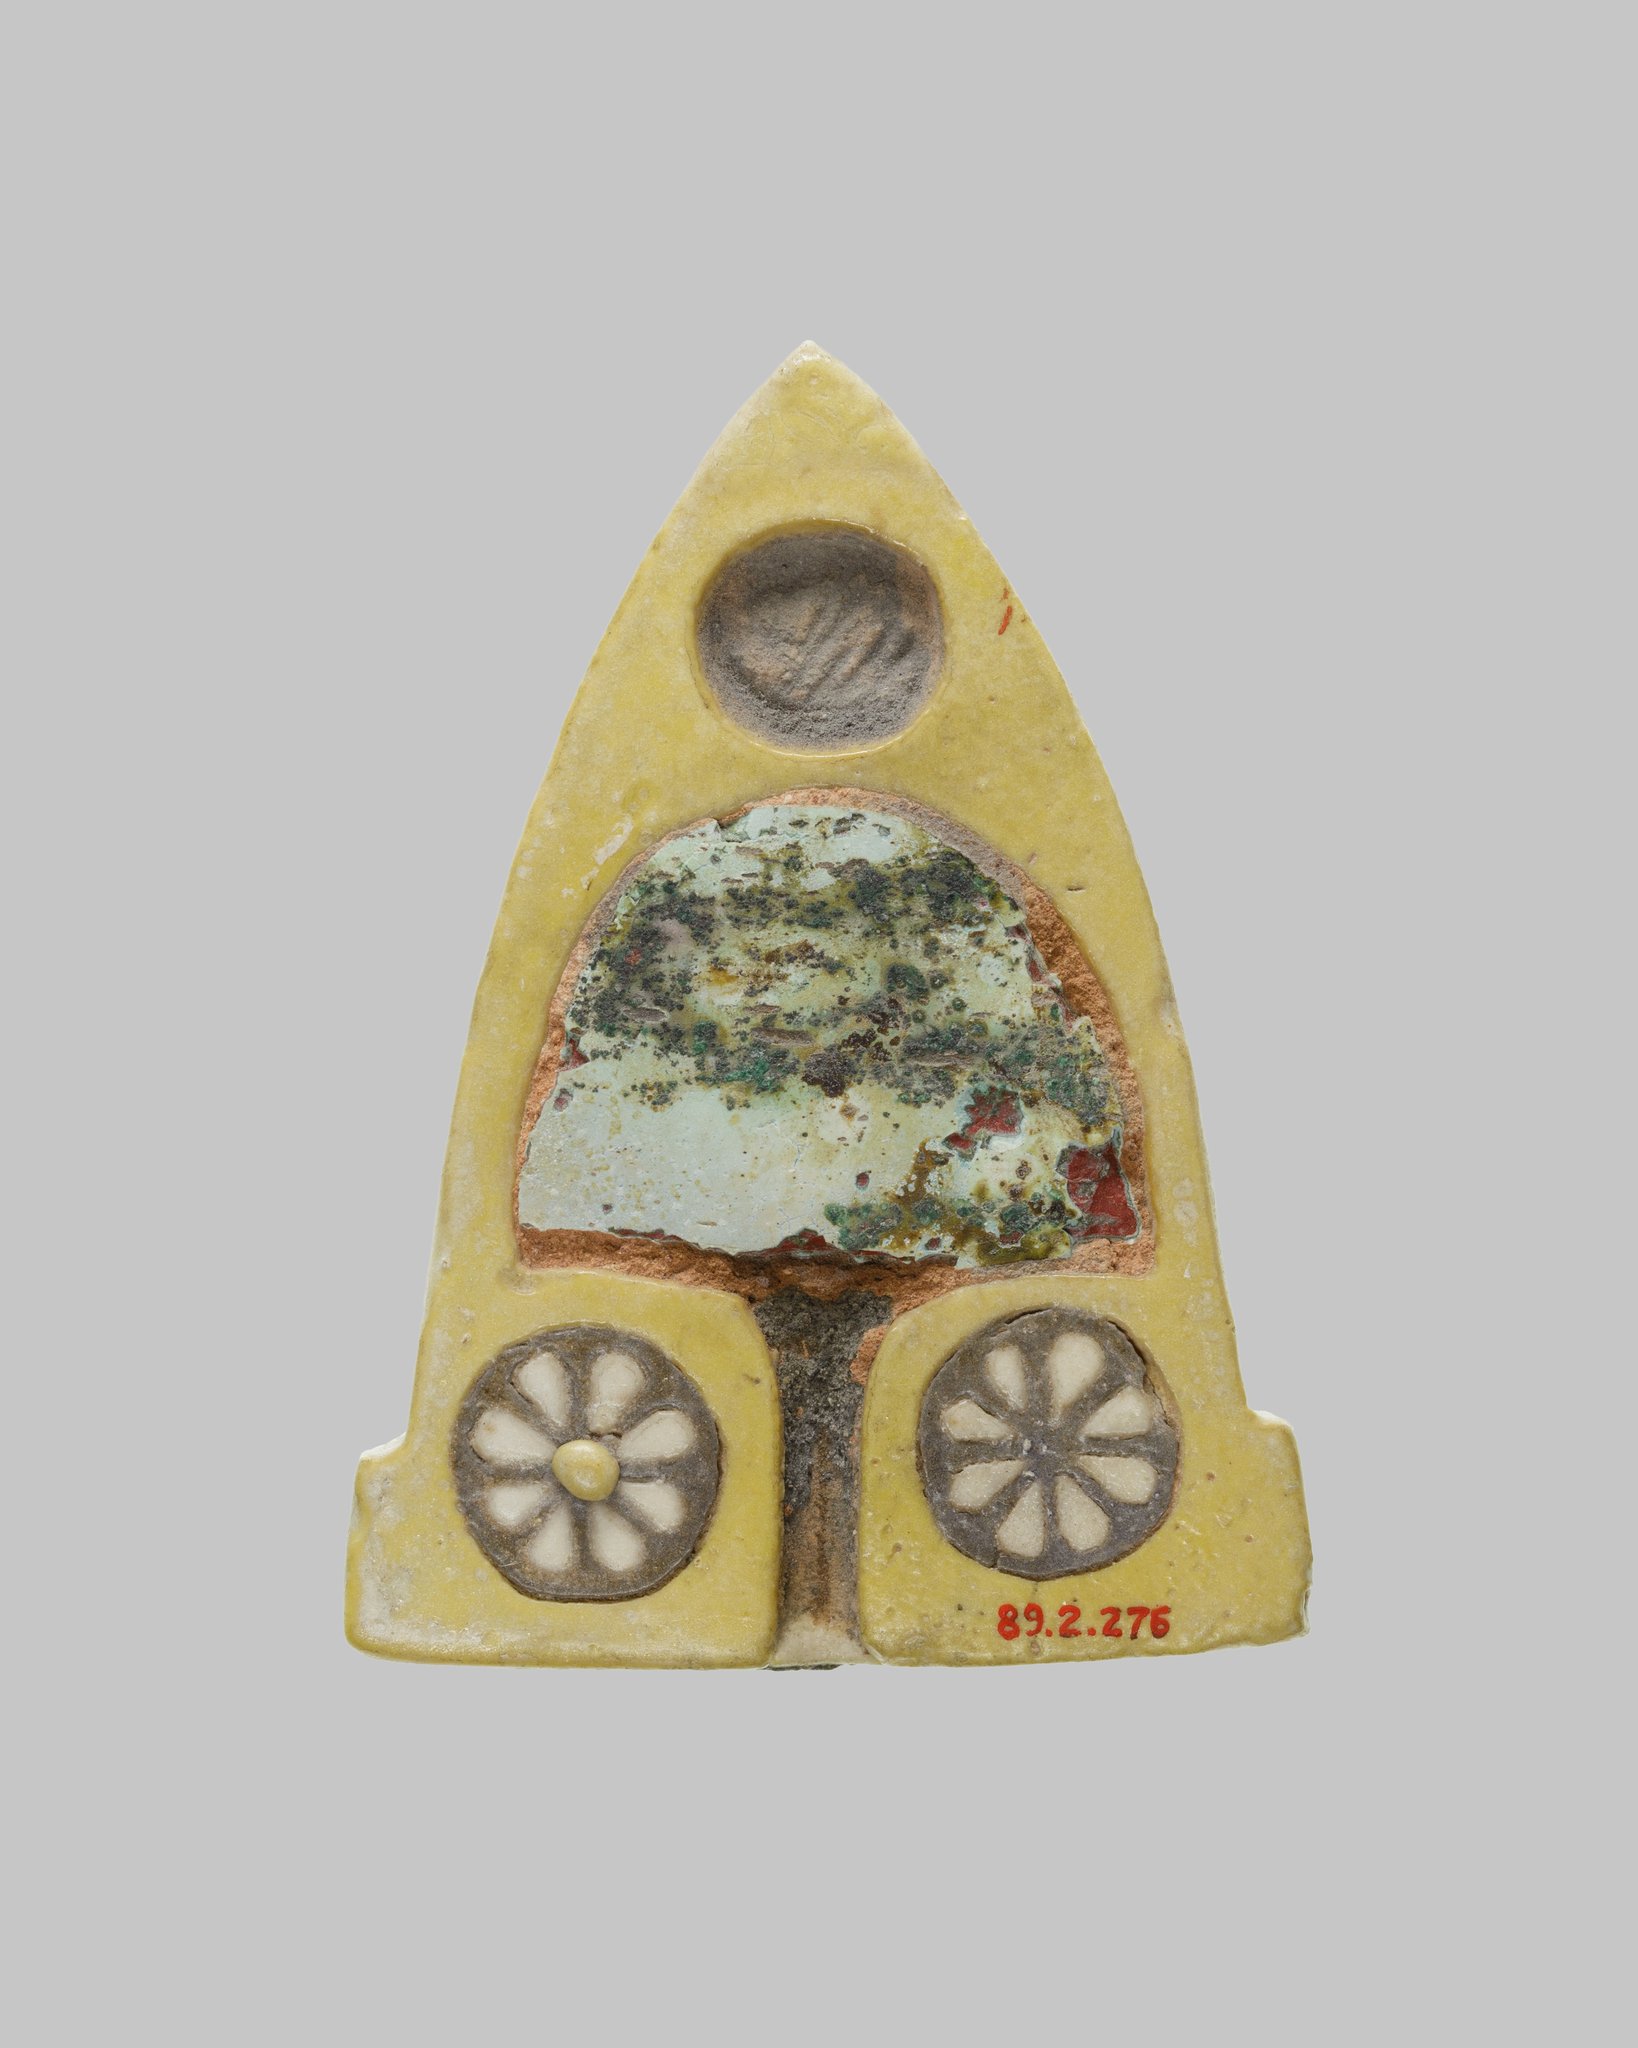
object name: inlay, lotus, lily, bud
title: Faience Inlay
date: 1184-1153 BCE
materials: faience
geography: egypt